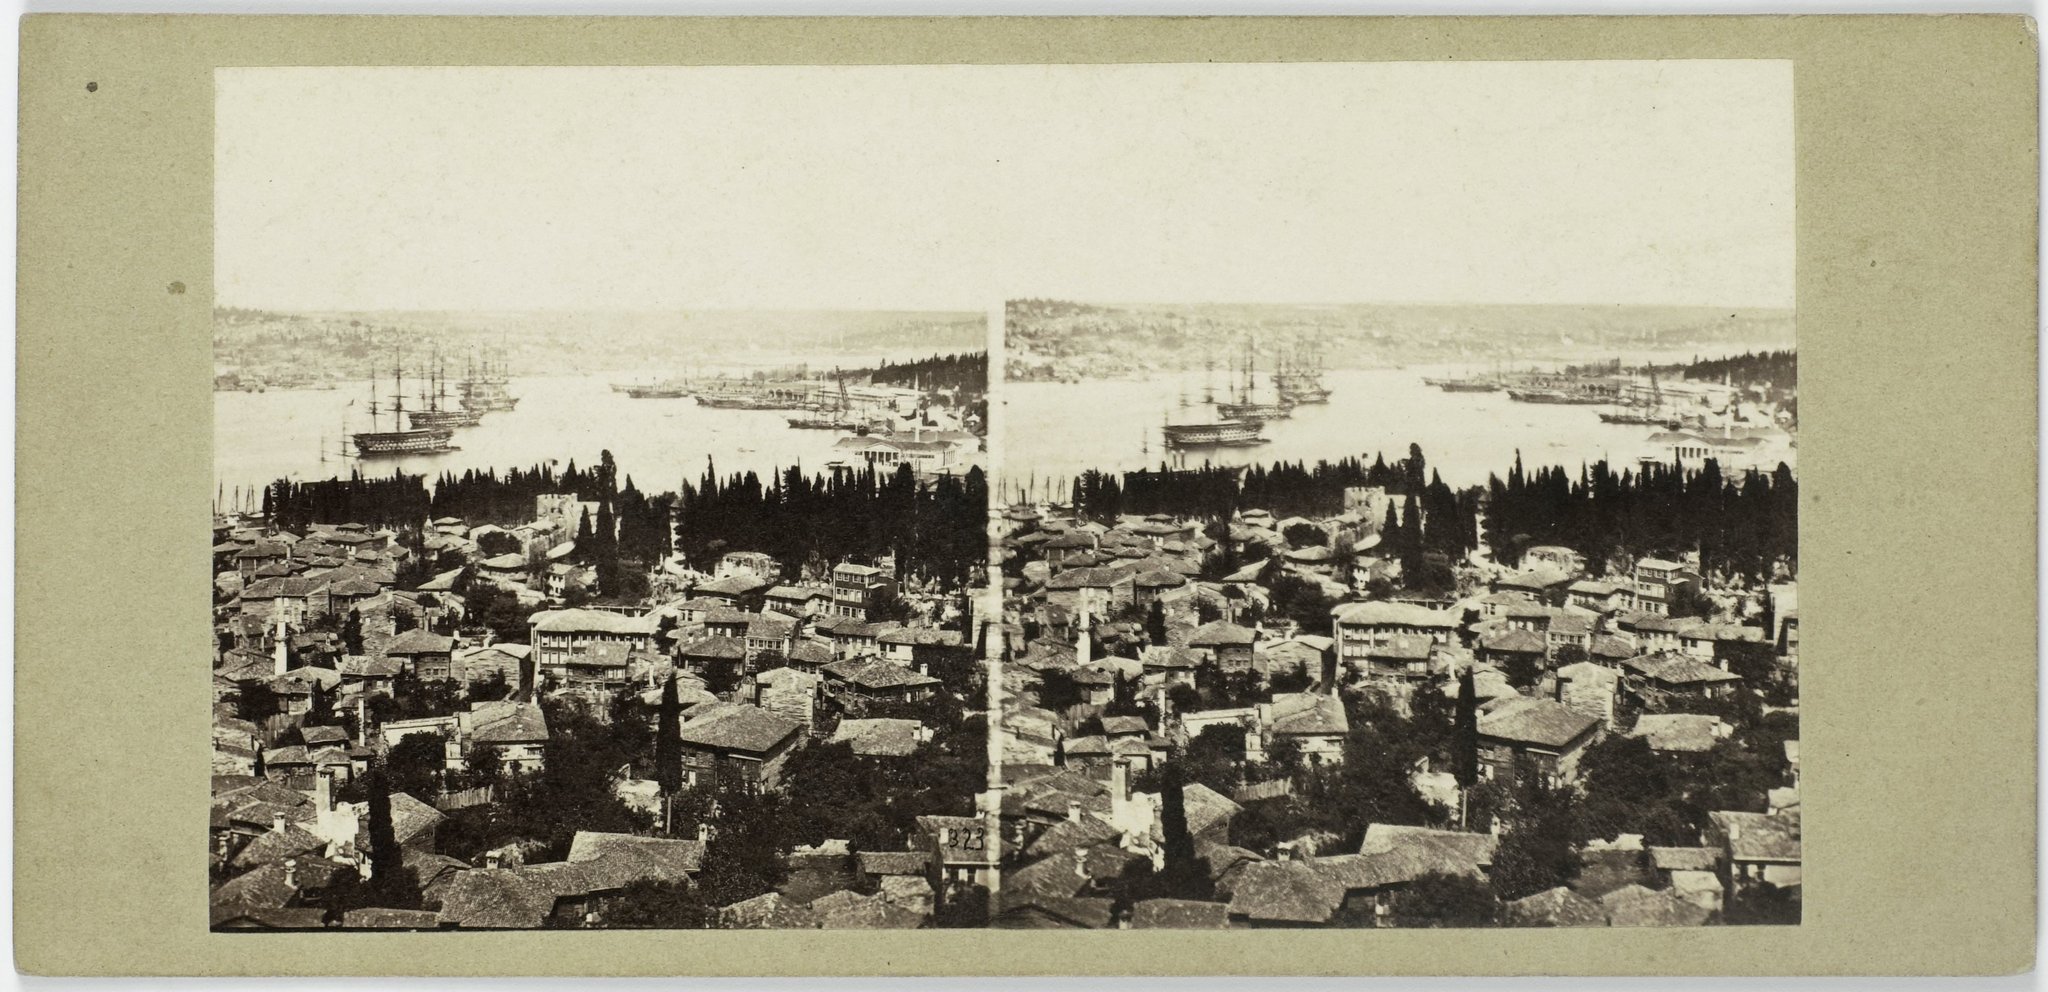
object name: stereograph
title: Panorama de Constantinople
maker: Anonymous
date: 1857-1870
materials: cardboard, paper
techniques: albumen print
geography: istanbul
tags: city-view in general; 'veduta'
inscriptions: retailer's mark: ‘Kunsthandlung/ Joh. Heinrigs/ CÖLN/ Hochstrasse 152/ Liefert alle im Jn. und Auslande/ erschienenen Kunstblätter.’, number: ‘1323’, number: ‘No 33’